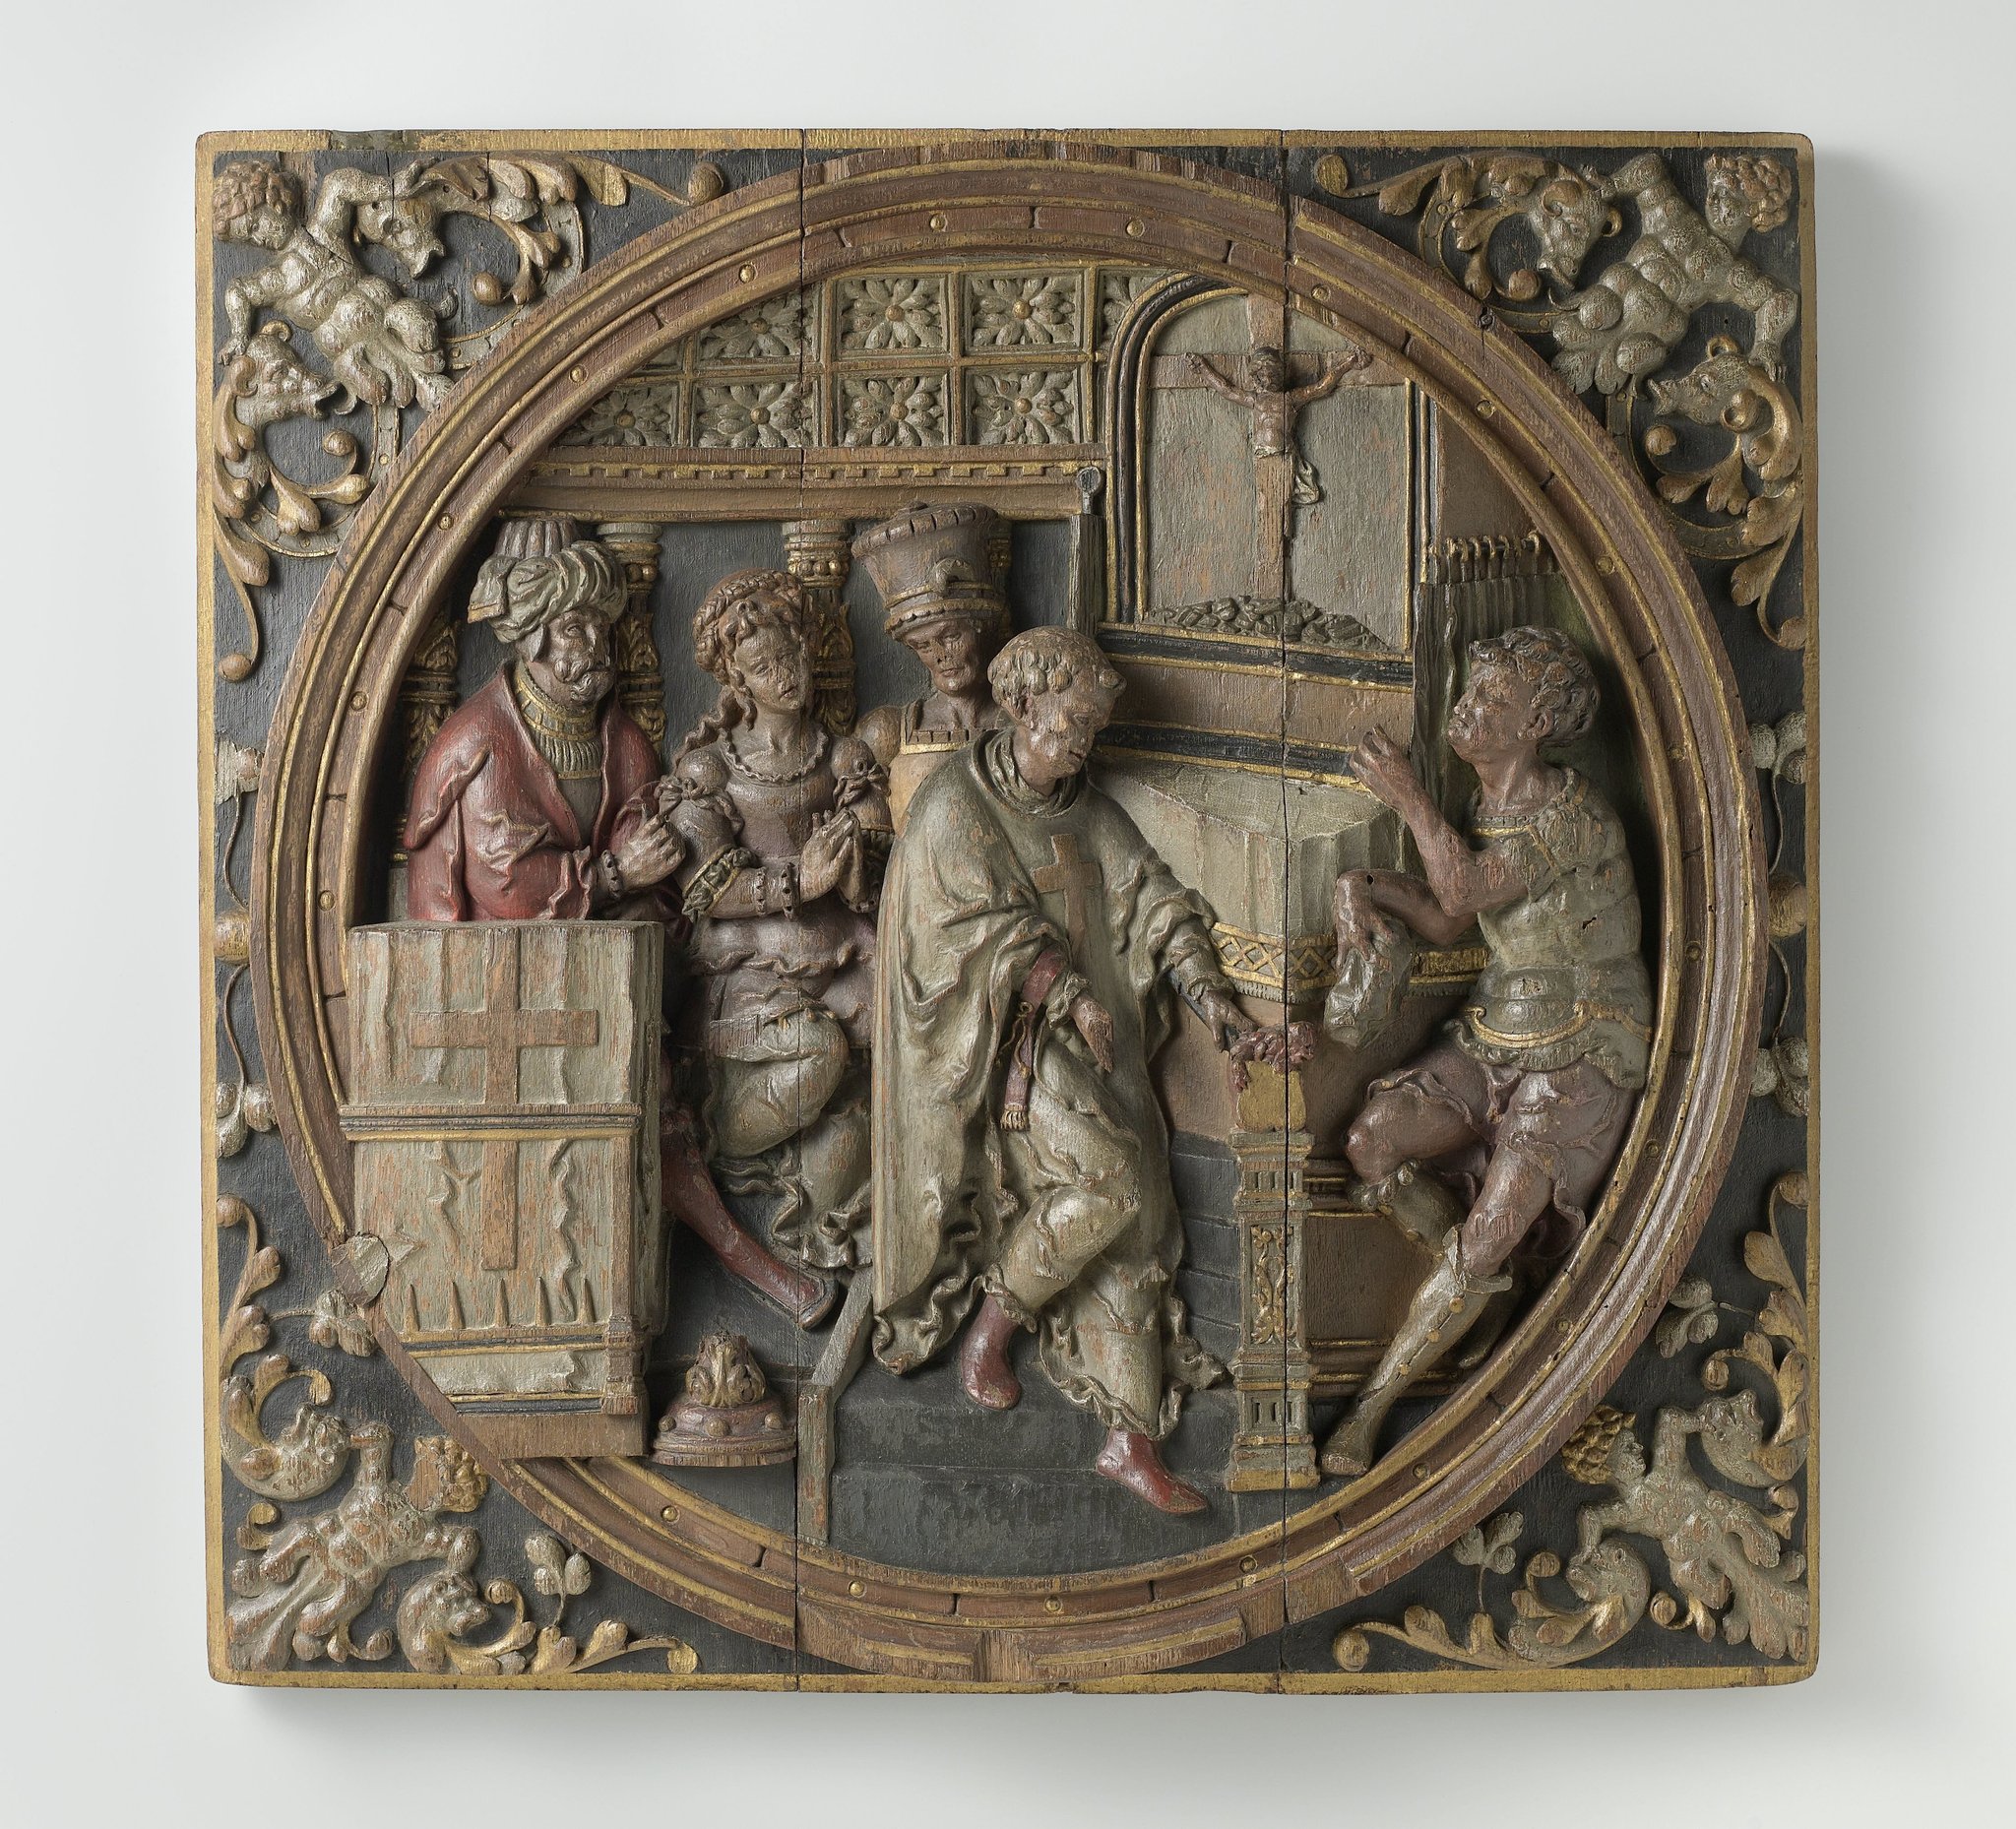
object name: sculpture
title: Confession (?)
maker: Anonymous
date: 1535-1565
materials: wood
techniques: polychromy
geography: gouda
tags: gouda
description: St. Clement's Mass. Oak, original polychromy. Holland, c. 1530-1540. From St. John's Church, Gouda.